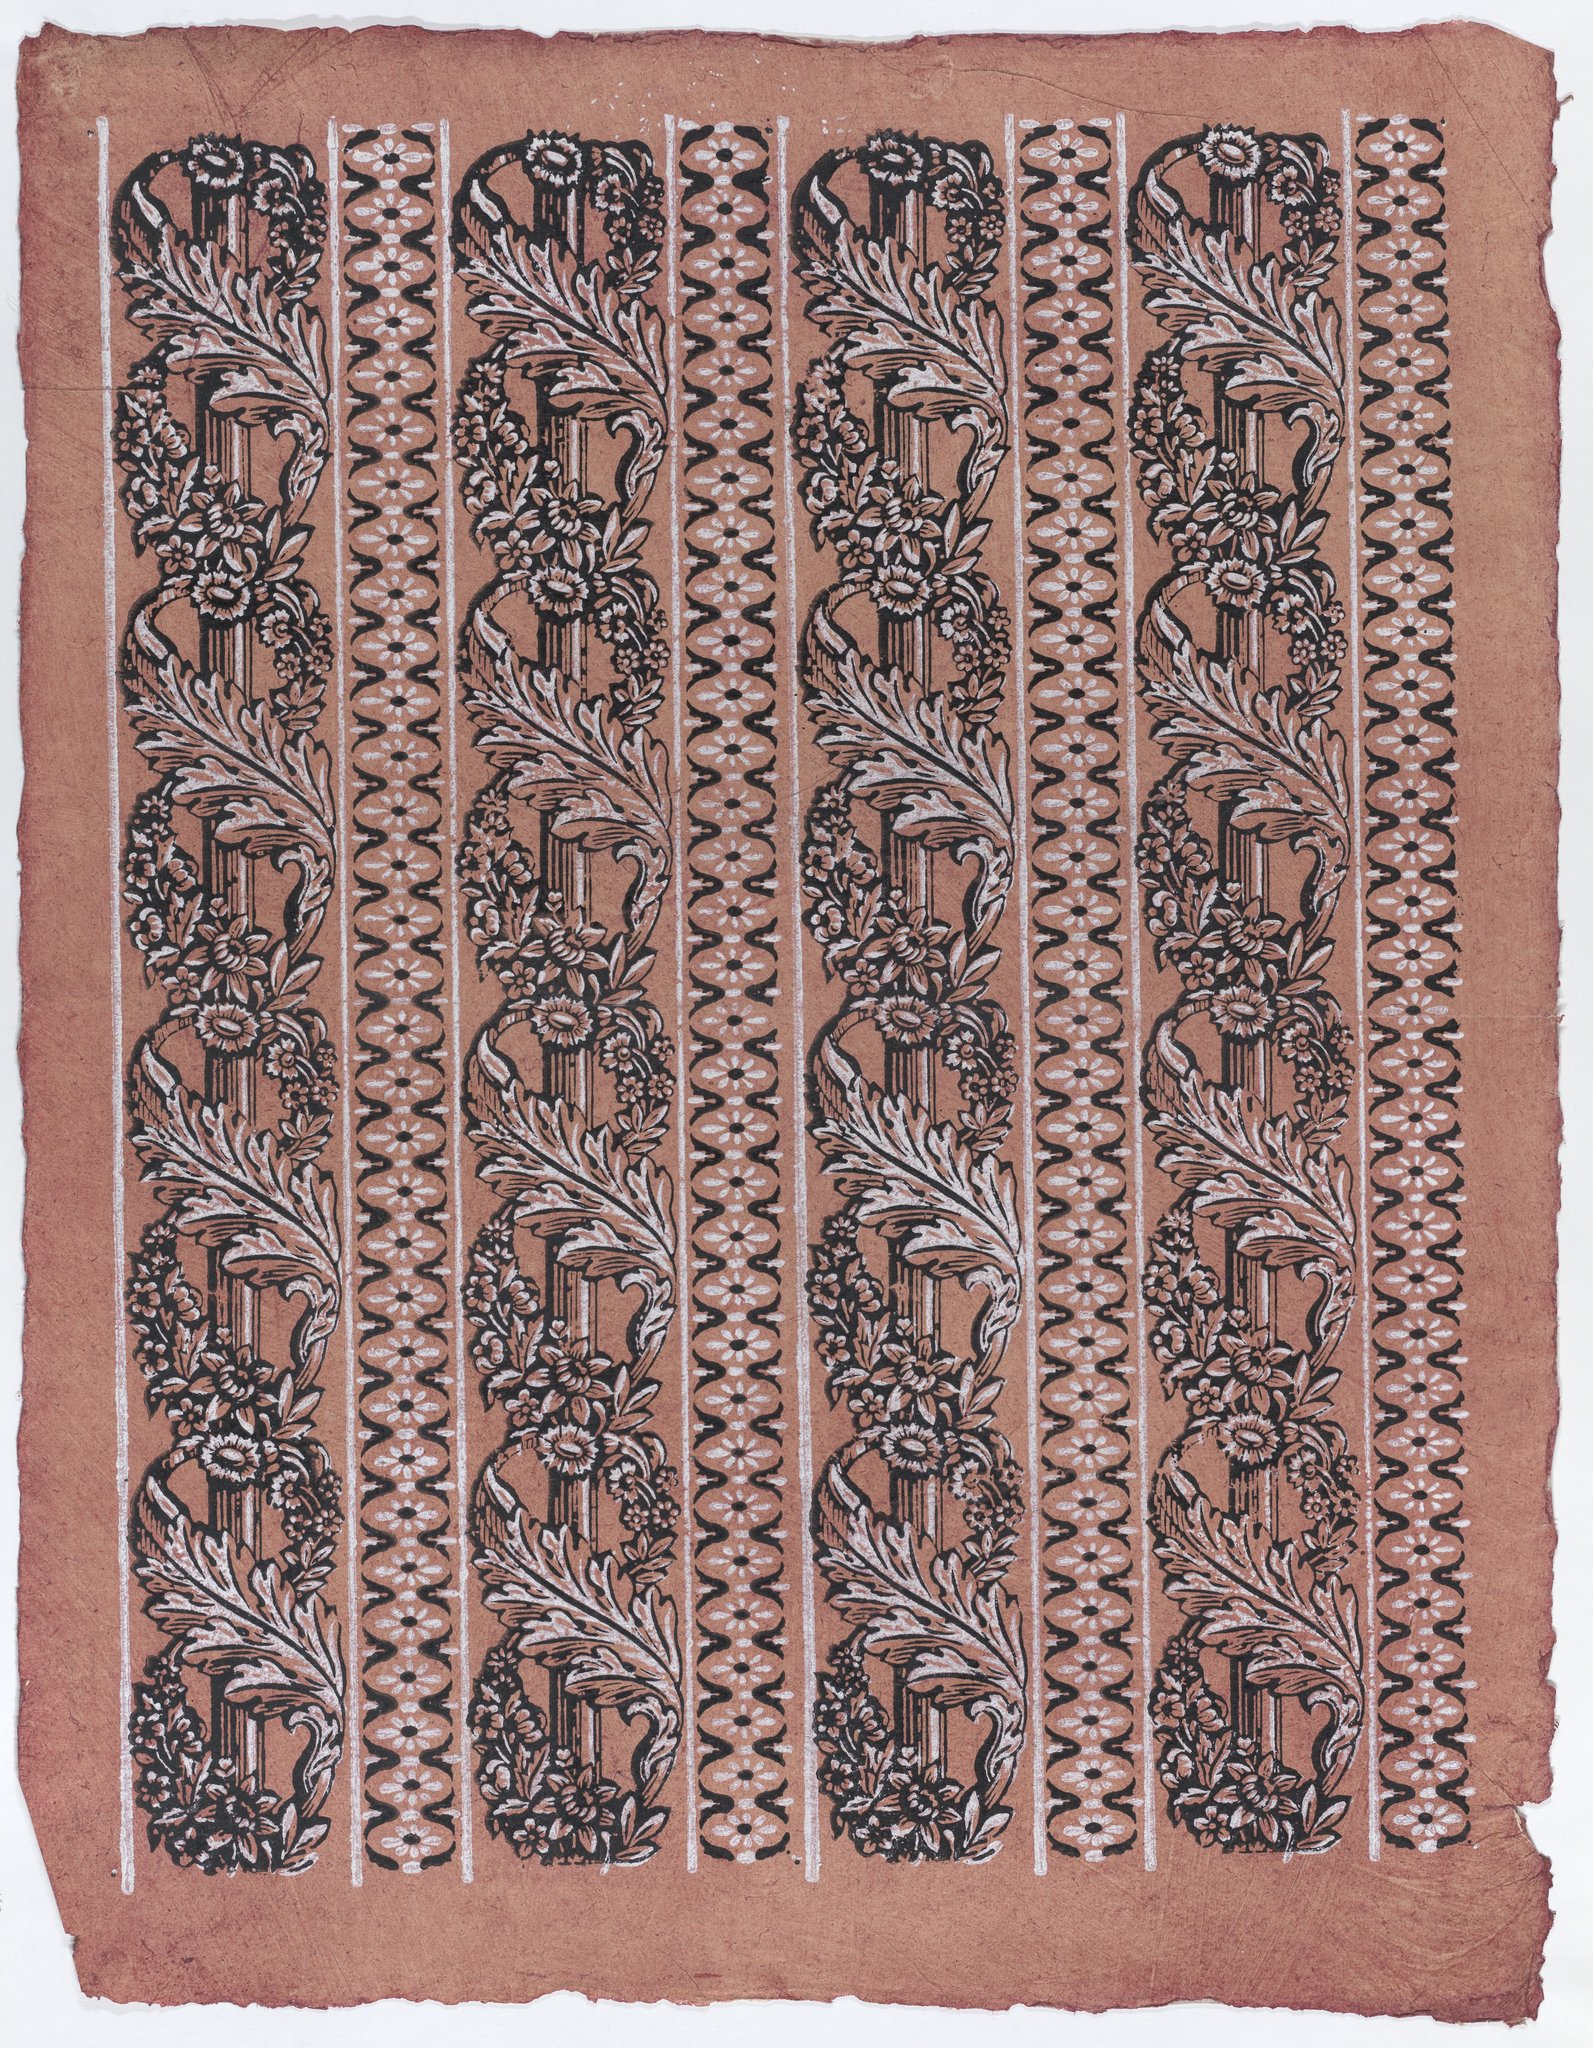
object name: print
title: Sheet with four borders with a garland of acanthus leaves and flowers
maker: Anonymous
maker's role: artist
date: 1767-1866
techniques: relief print